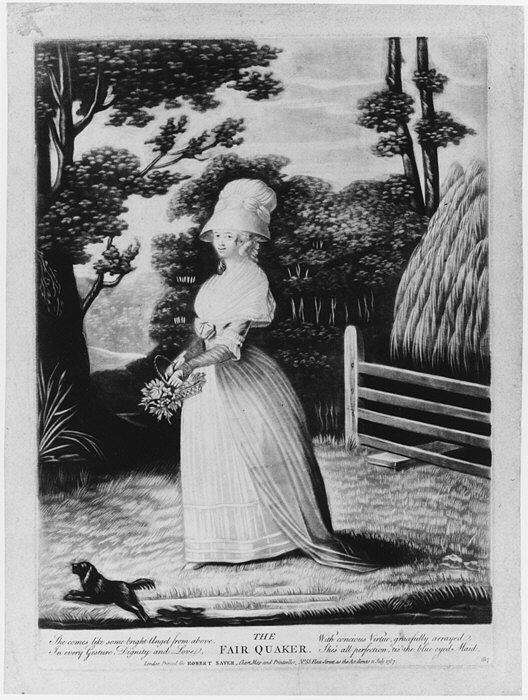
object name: print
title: The Fair Quaker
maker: anonymous, british, 18th century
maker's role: artist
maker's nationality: british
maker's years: 1700-1800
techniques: mezzotint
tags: women,dogs